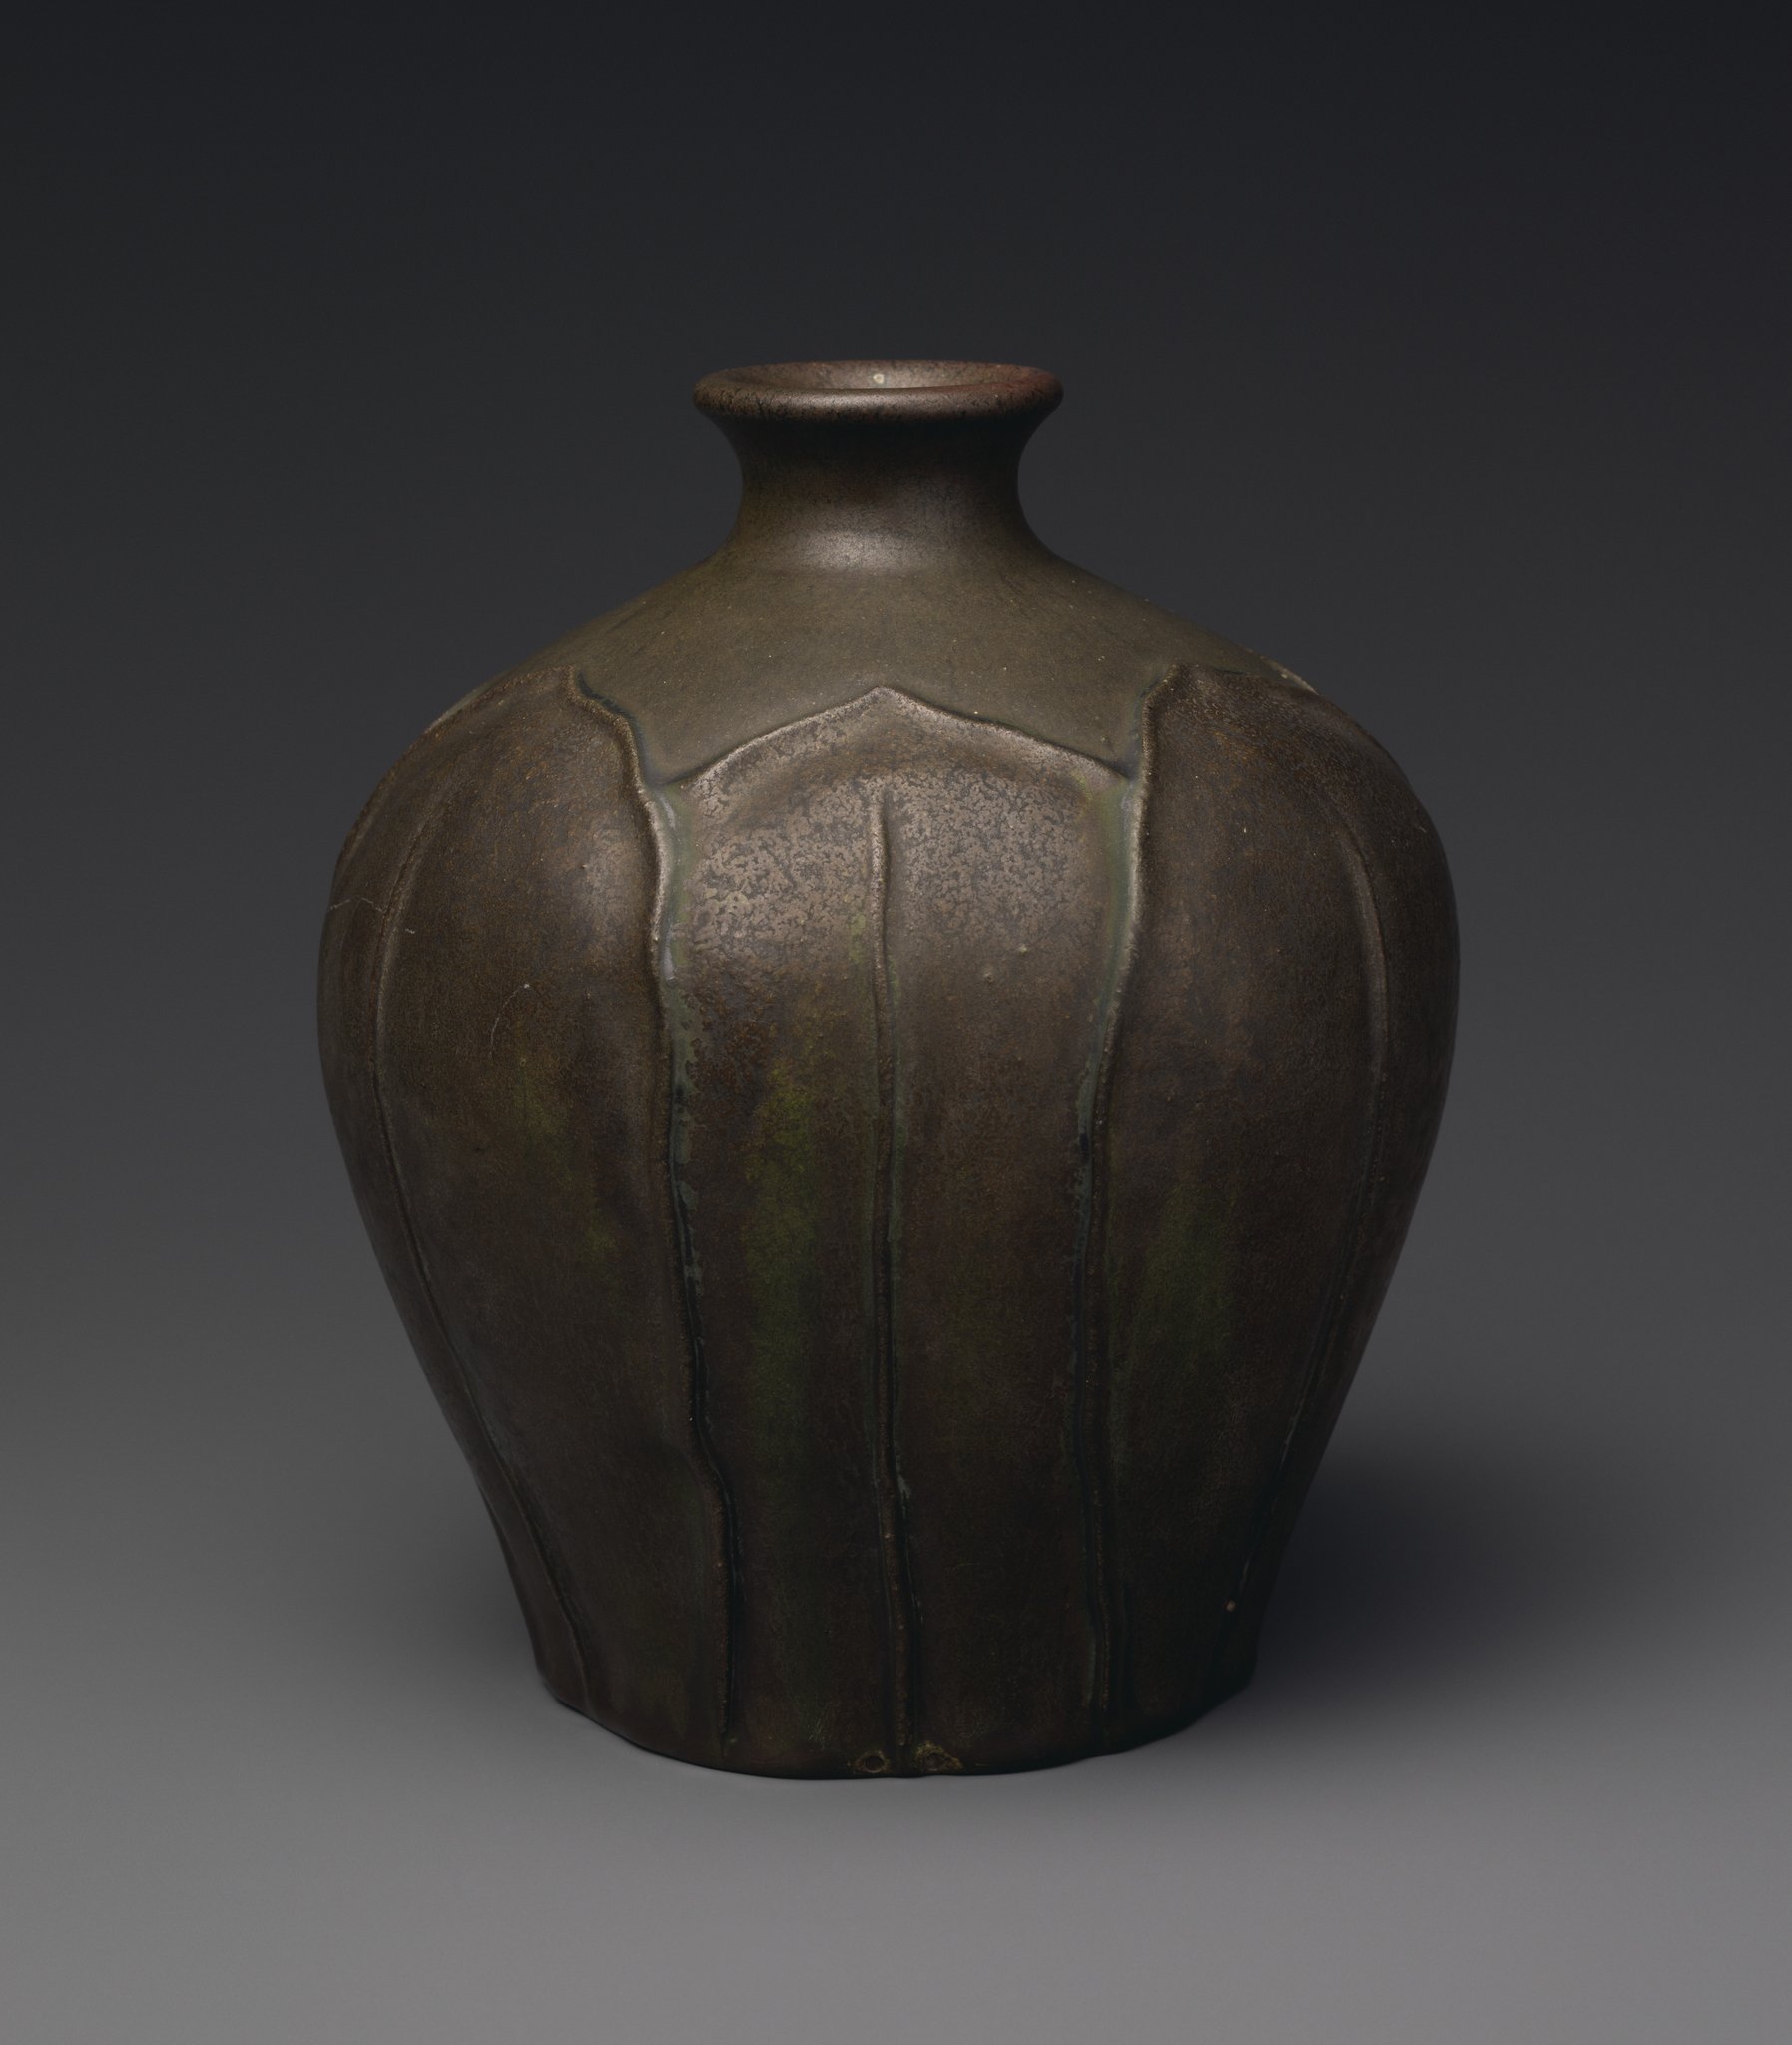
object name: vase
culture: american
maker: william j. walley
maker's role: maker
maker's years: 1852-1919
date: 1898-1918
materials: earthenware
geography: united states